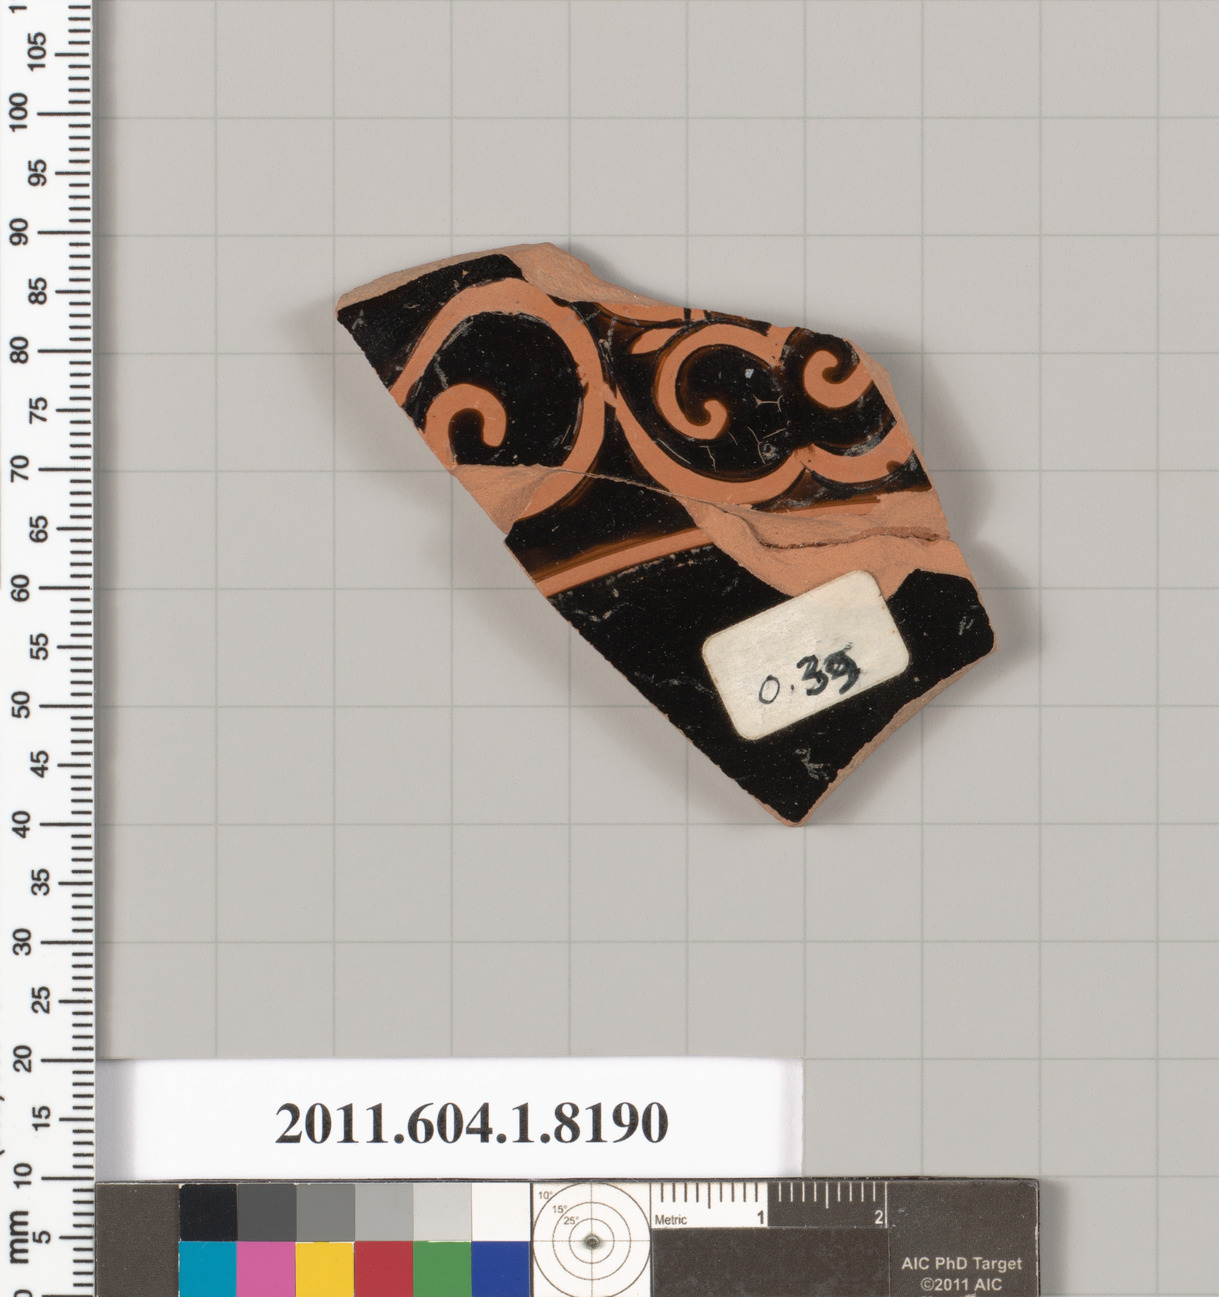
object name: kylix fragment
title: Terracotta fragment of a kylix (drinking cup)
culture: greek, attic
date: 534-468 BCE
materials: terracotta